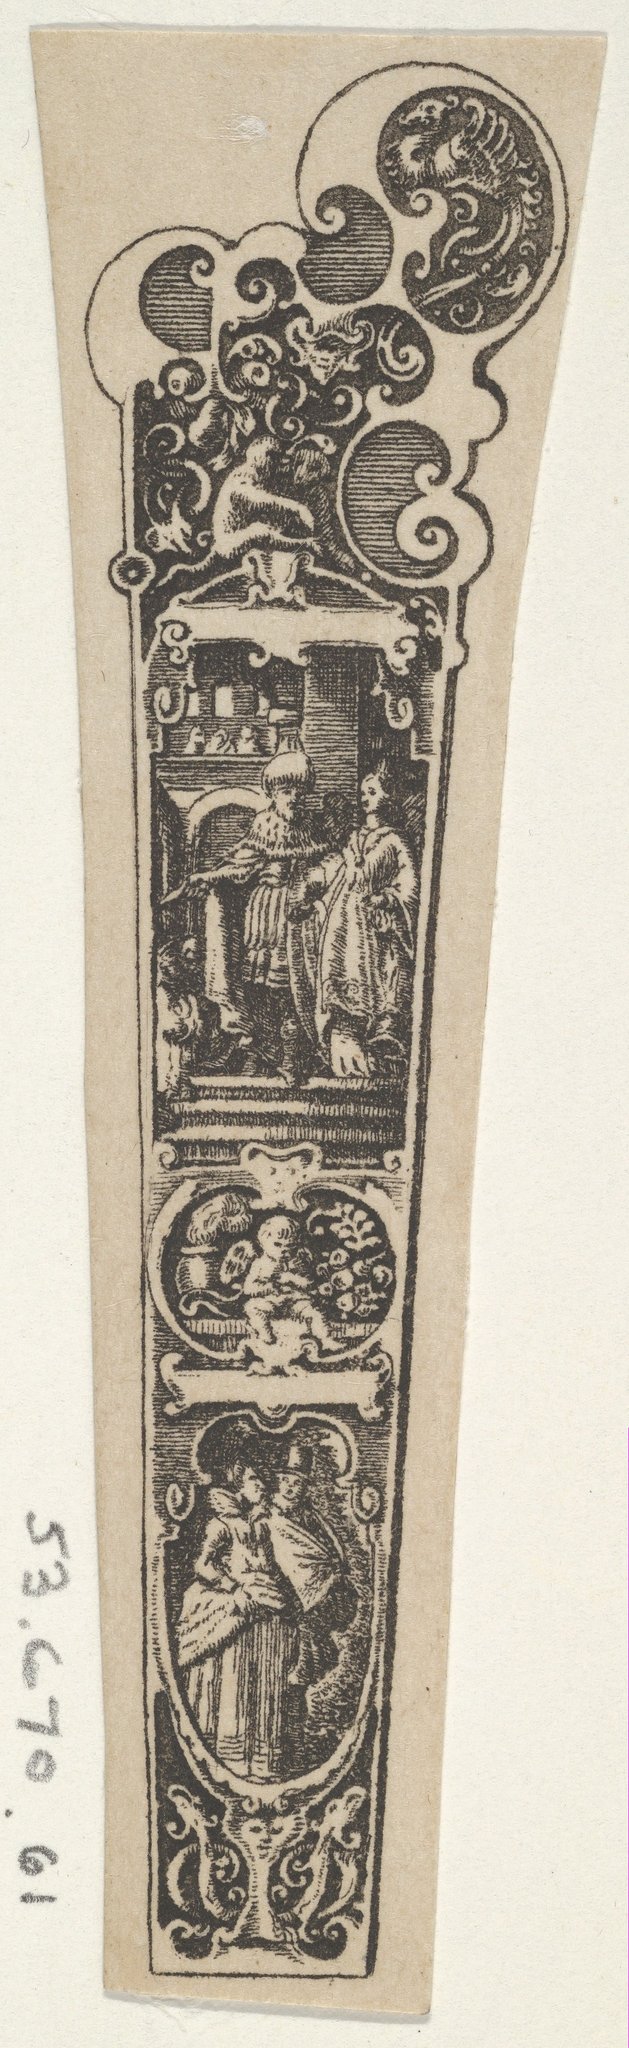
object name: print ornament architecture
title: Design for a Knife Handle with Well-Dressed Couples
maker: johann theodor de bry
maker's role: artist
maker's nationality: netherlandish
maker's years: 1561-1623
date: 1580-1600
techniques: embroidery, engraving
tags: birds,couples,men,women